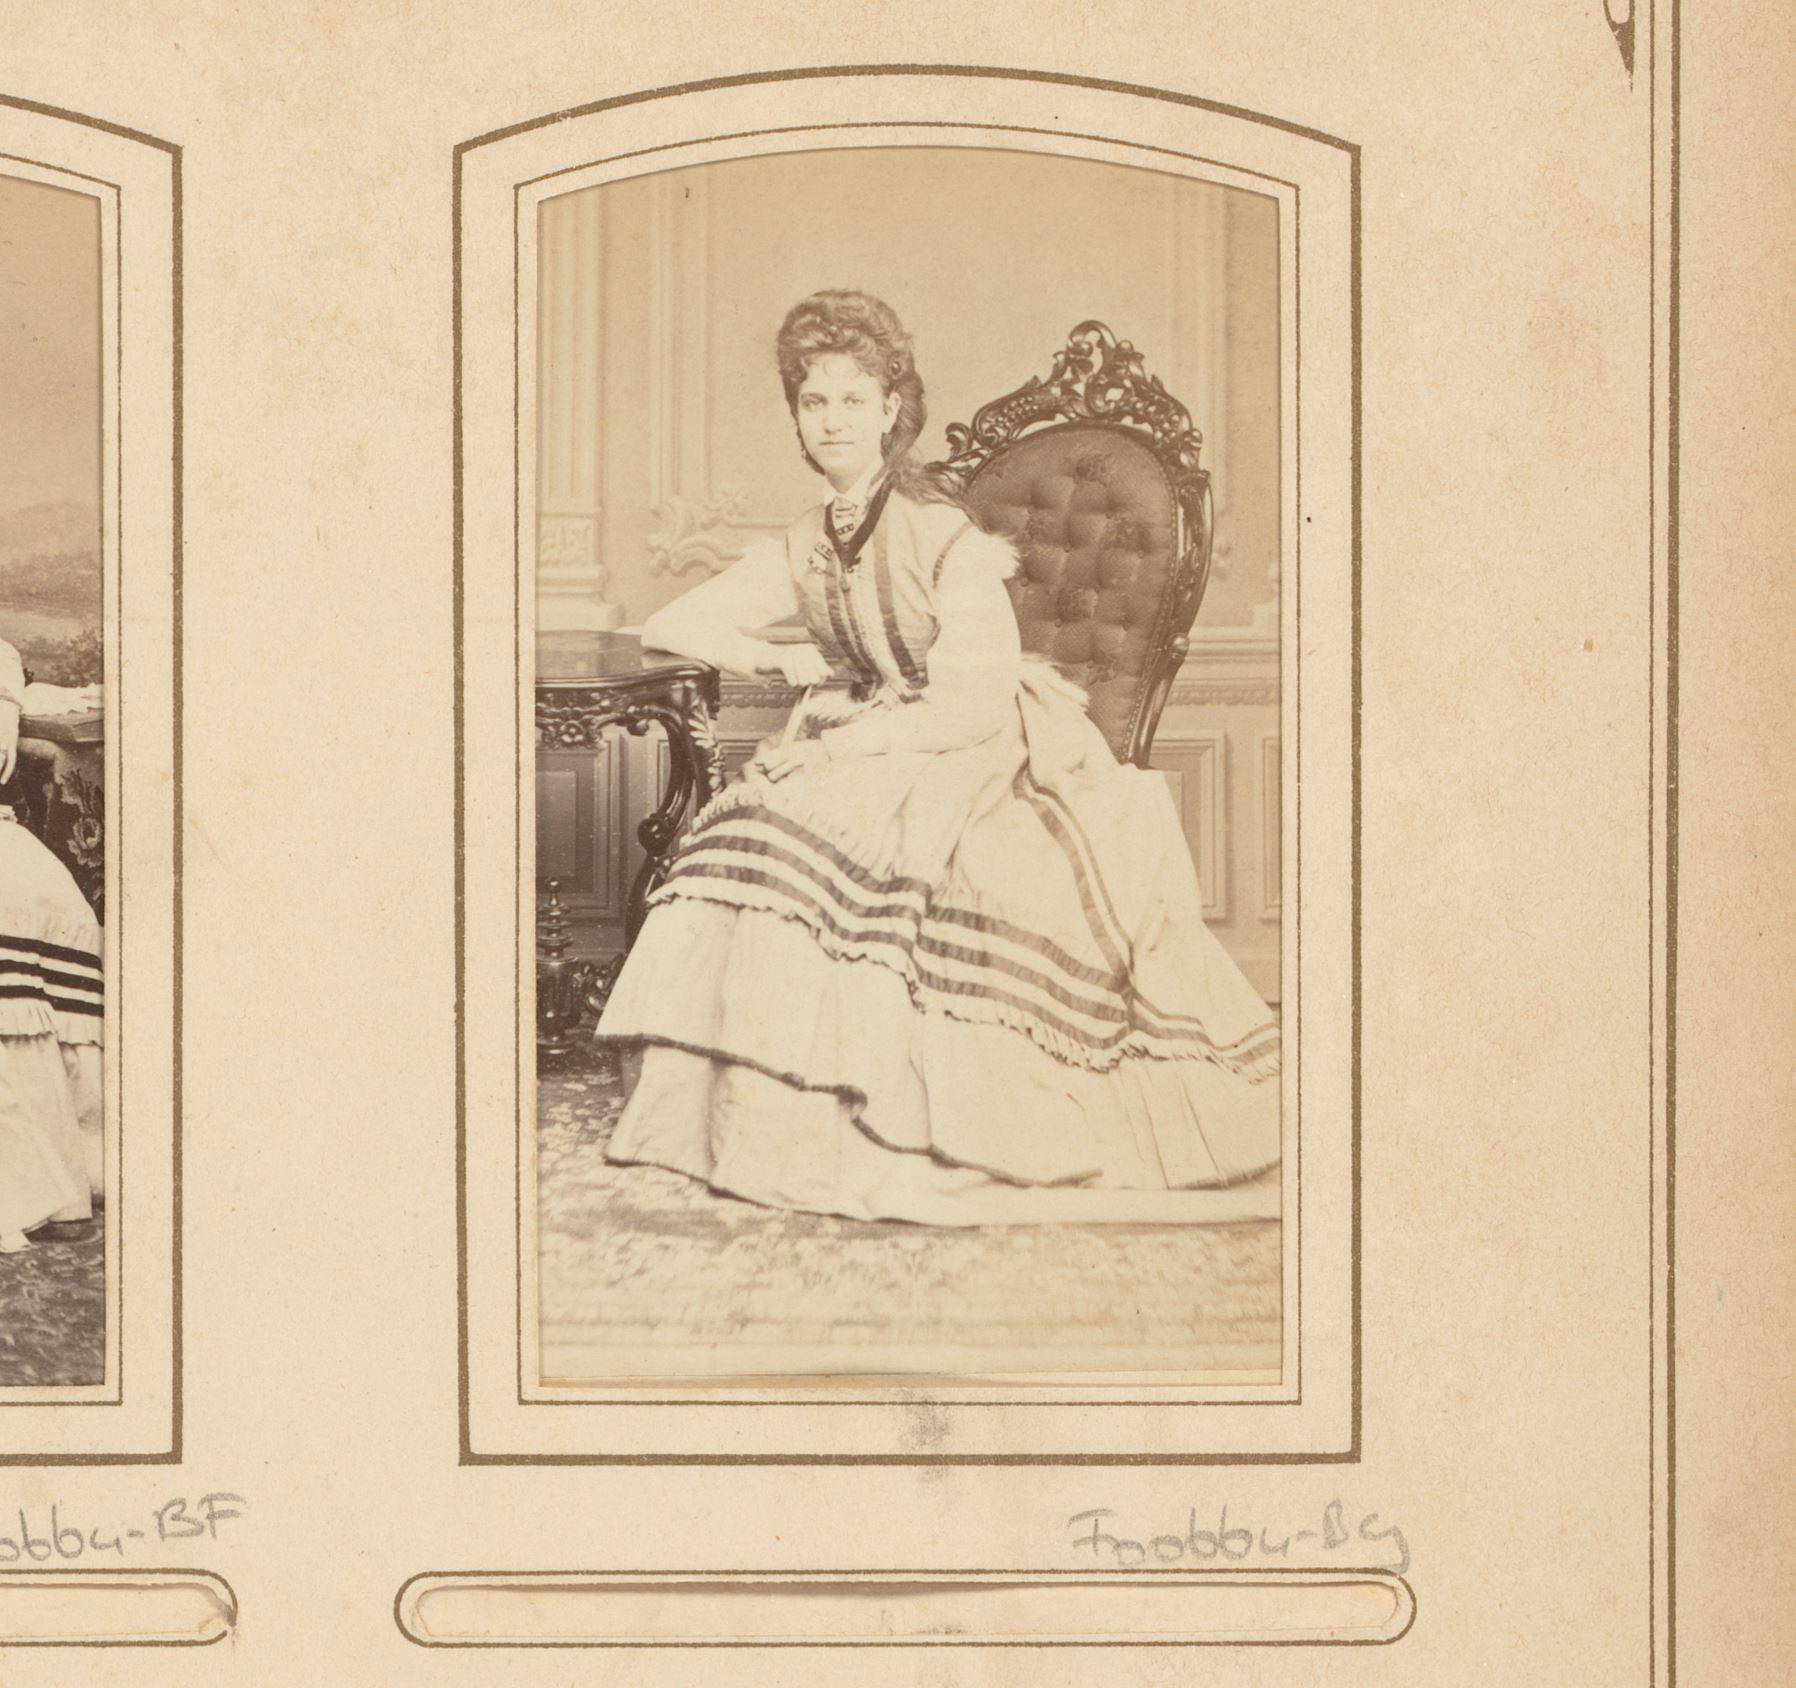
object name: photograph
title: Portret van een vrouw in een witte jurk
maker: c. perret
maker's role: fotograaf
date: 1872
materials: cardboard, photographic support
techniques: albumen print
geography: java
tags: historical persons - bb - woman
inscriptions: inscription: ‘C. Perret/ Photograaf/ Java’, annotation: ‘Koningin Elizabeth/ 1 Oktober/ 1872’